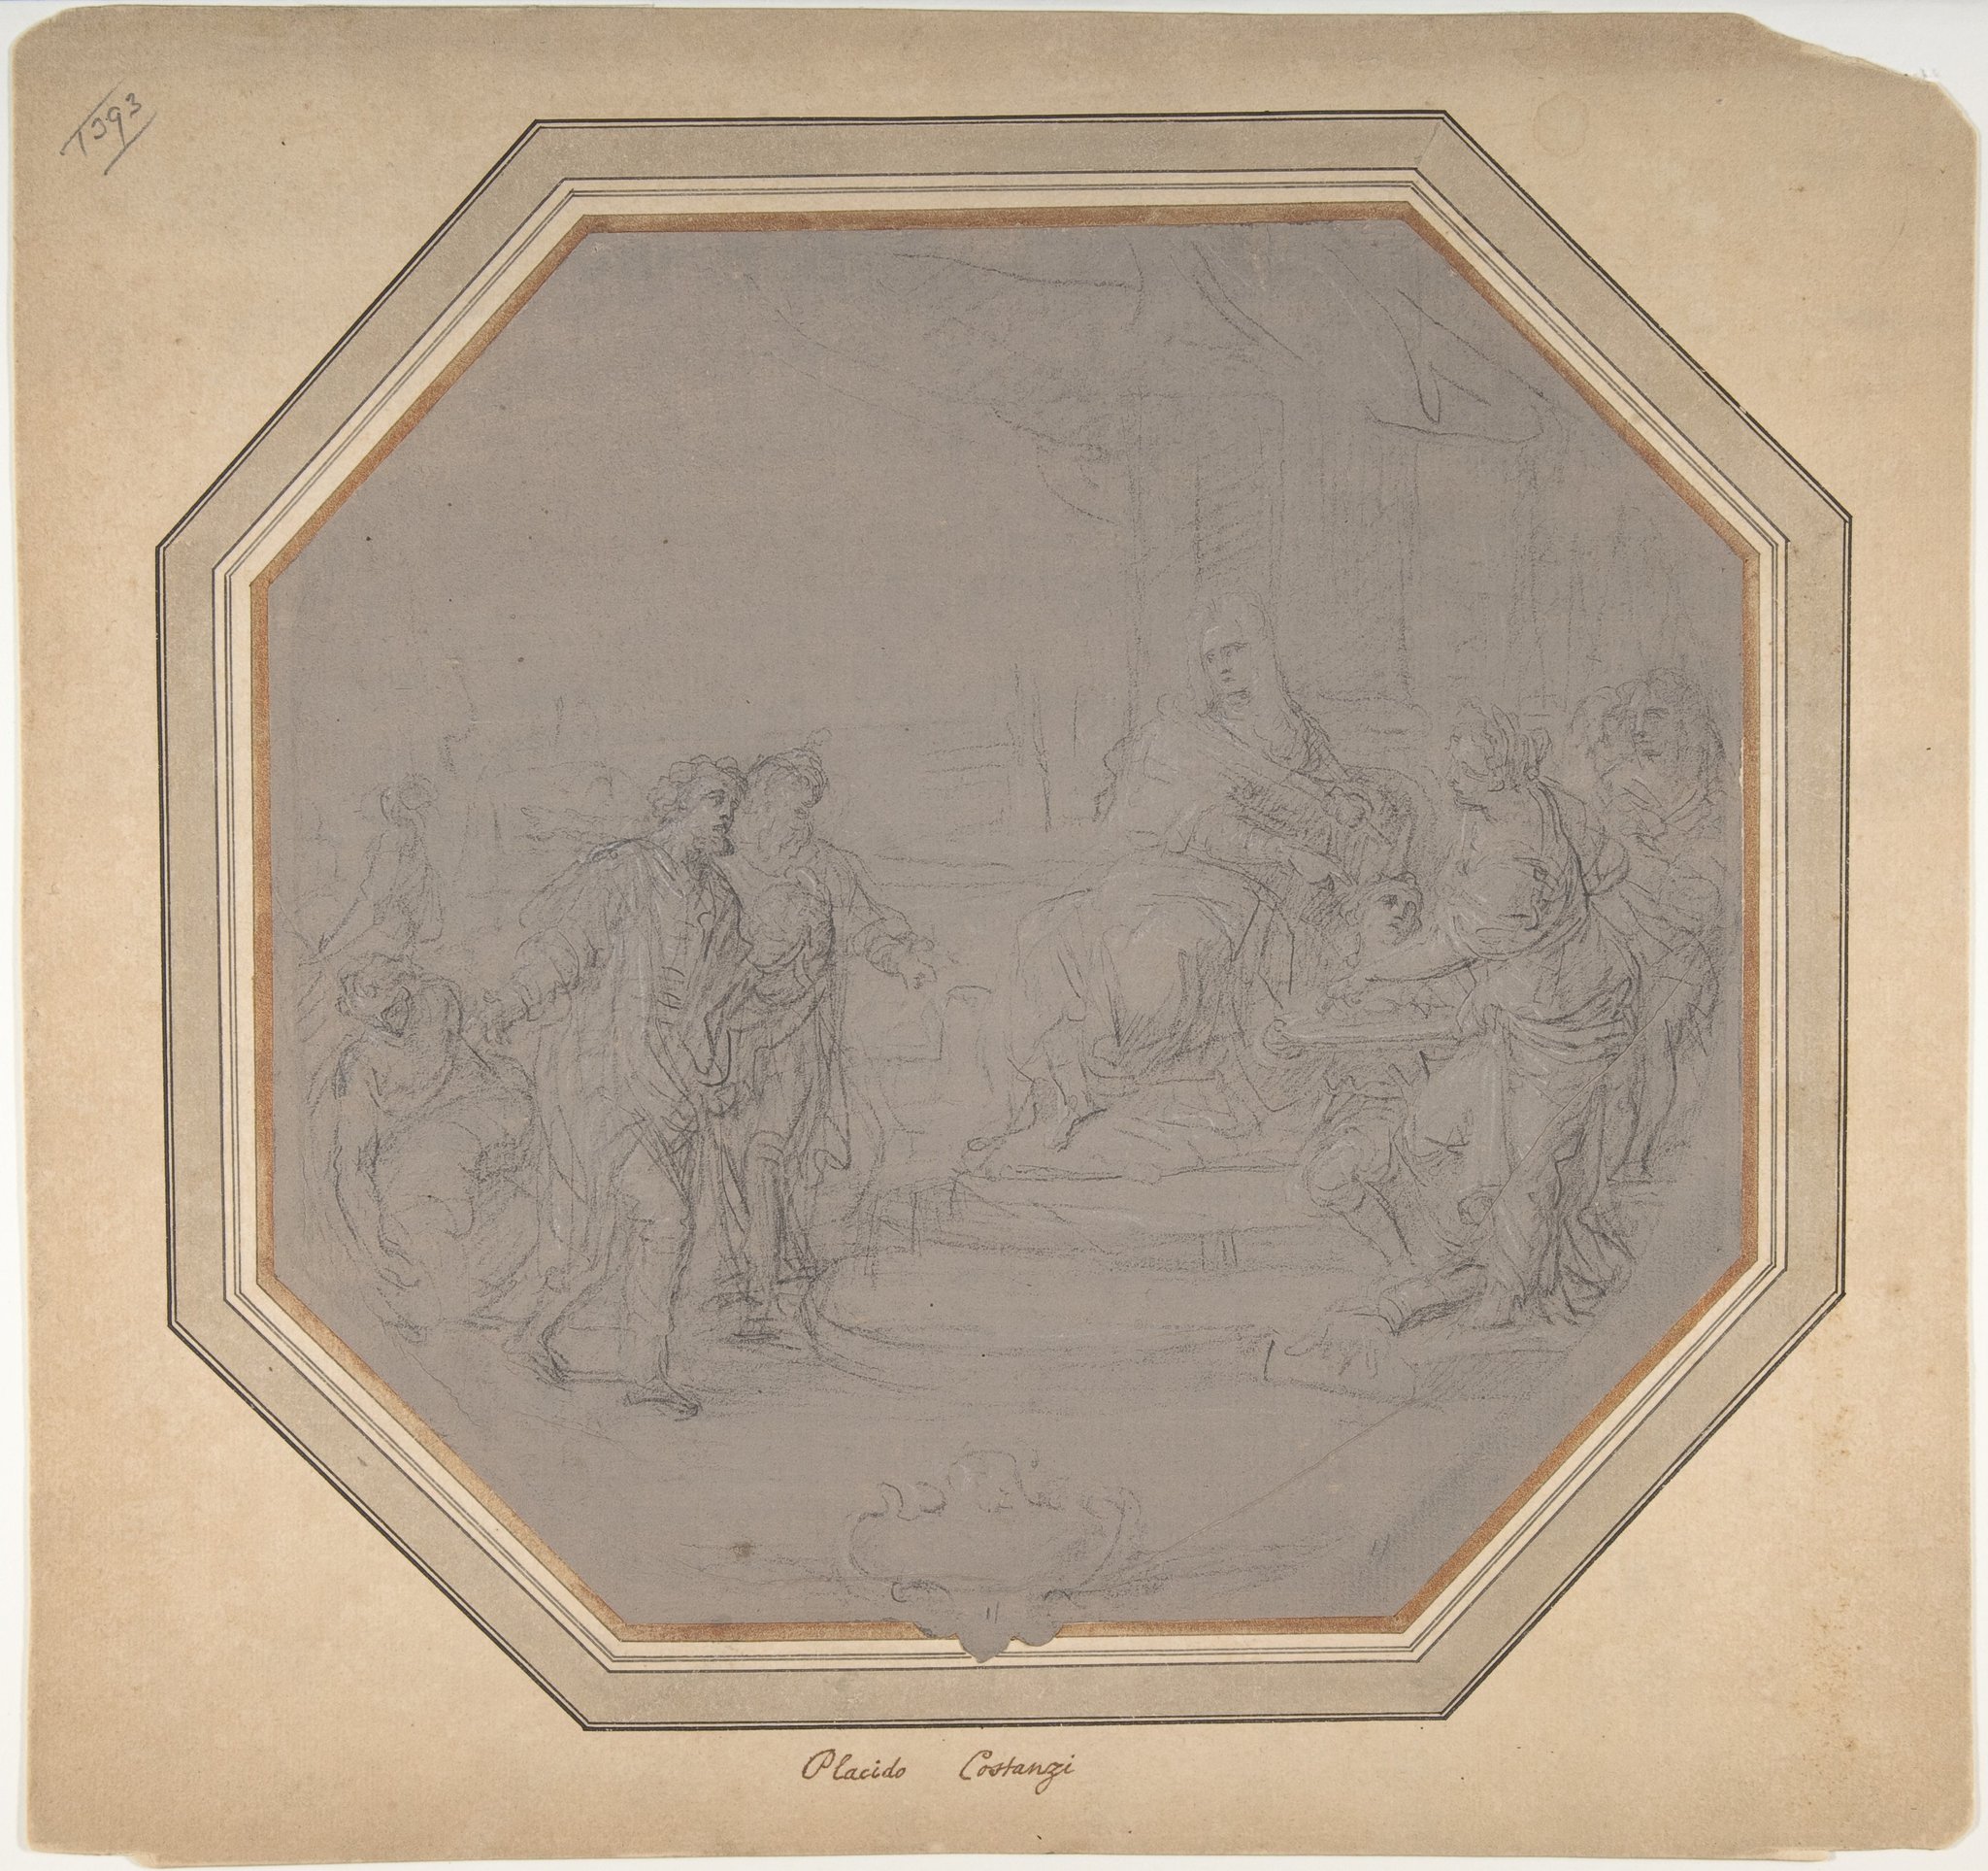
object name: drawing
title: Unidentified Subject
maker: placido costanzi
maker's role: artist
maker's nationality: italian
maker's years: 1702-1759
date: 1702-1759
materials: chalk, paper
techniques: highlighting, wash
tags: men,women